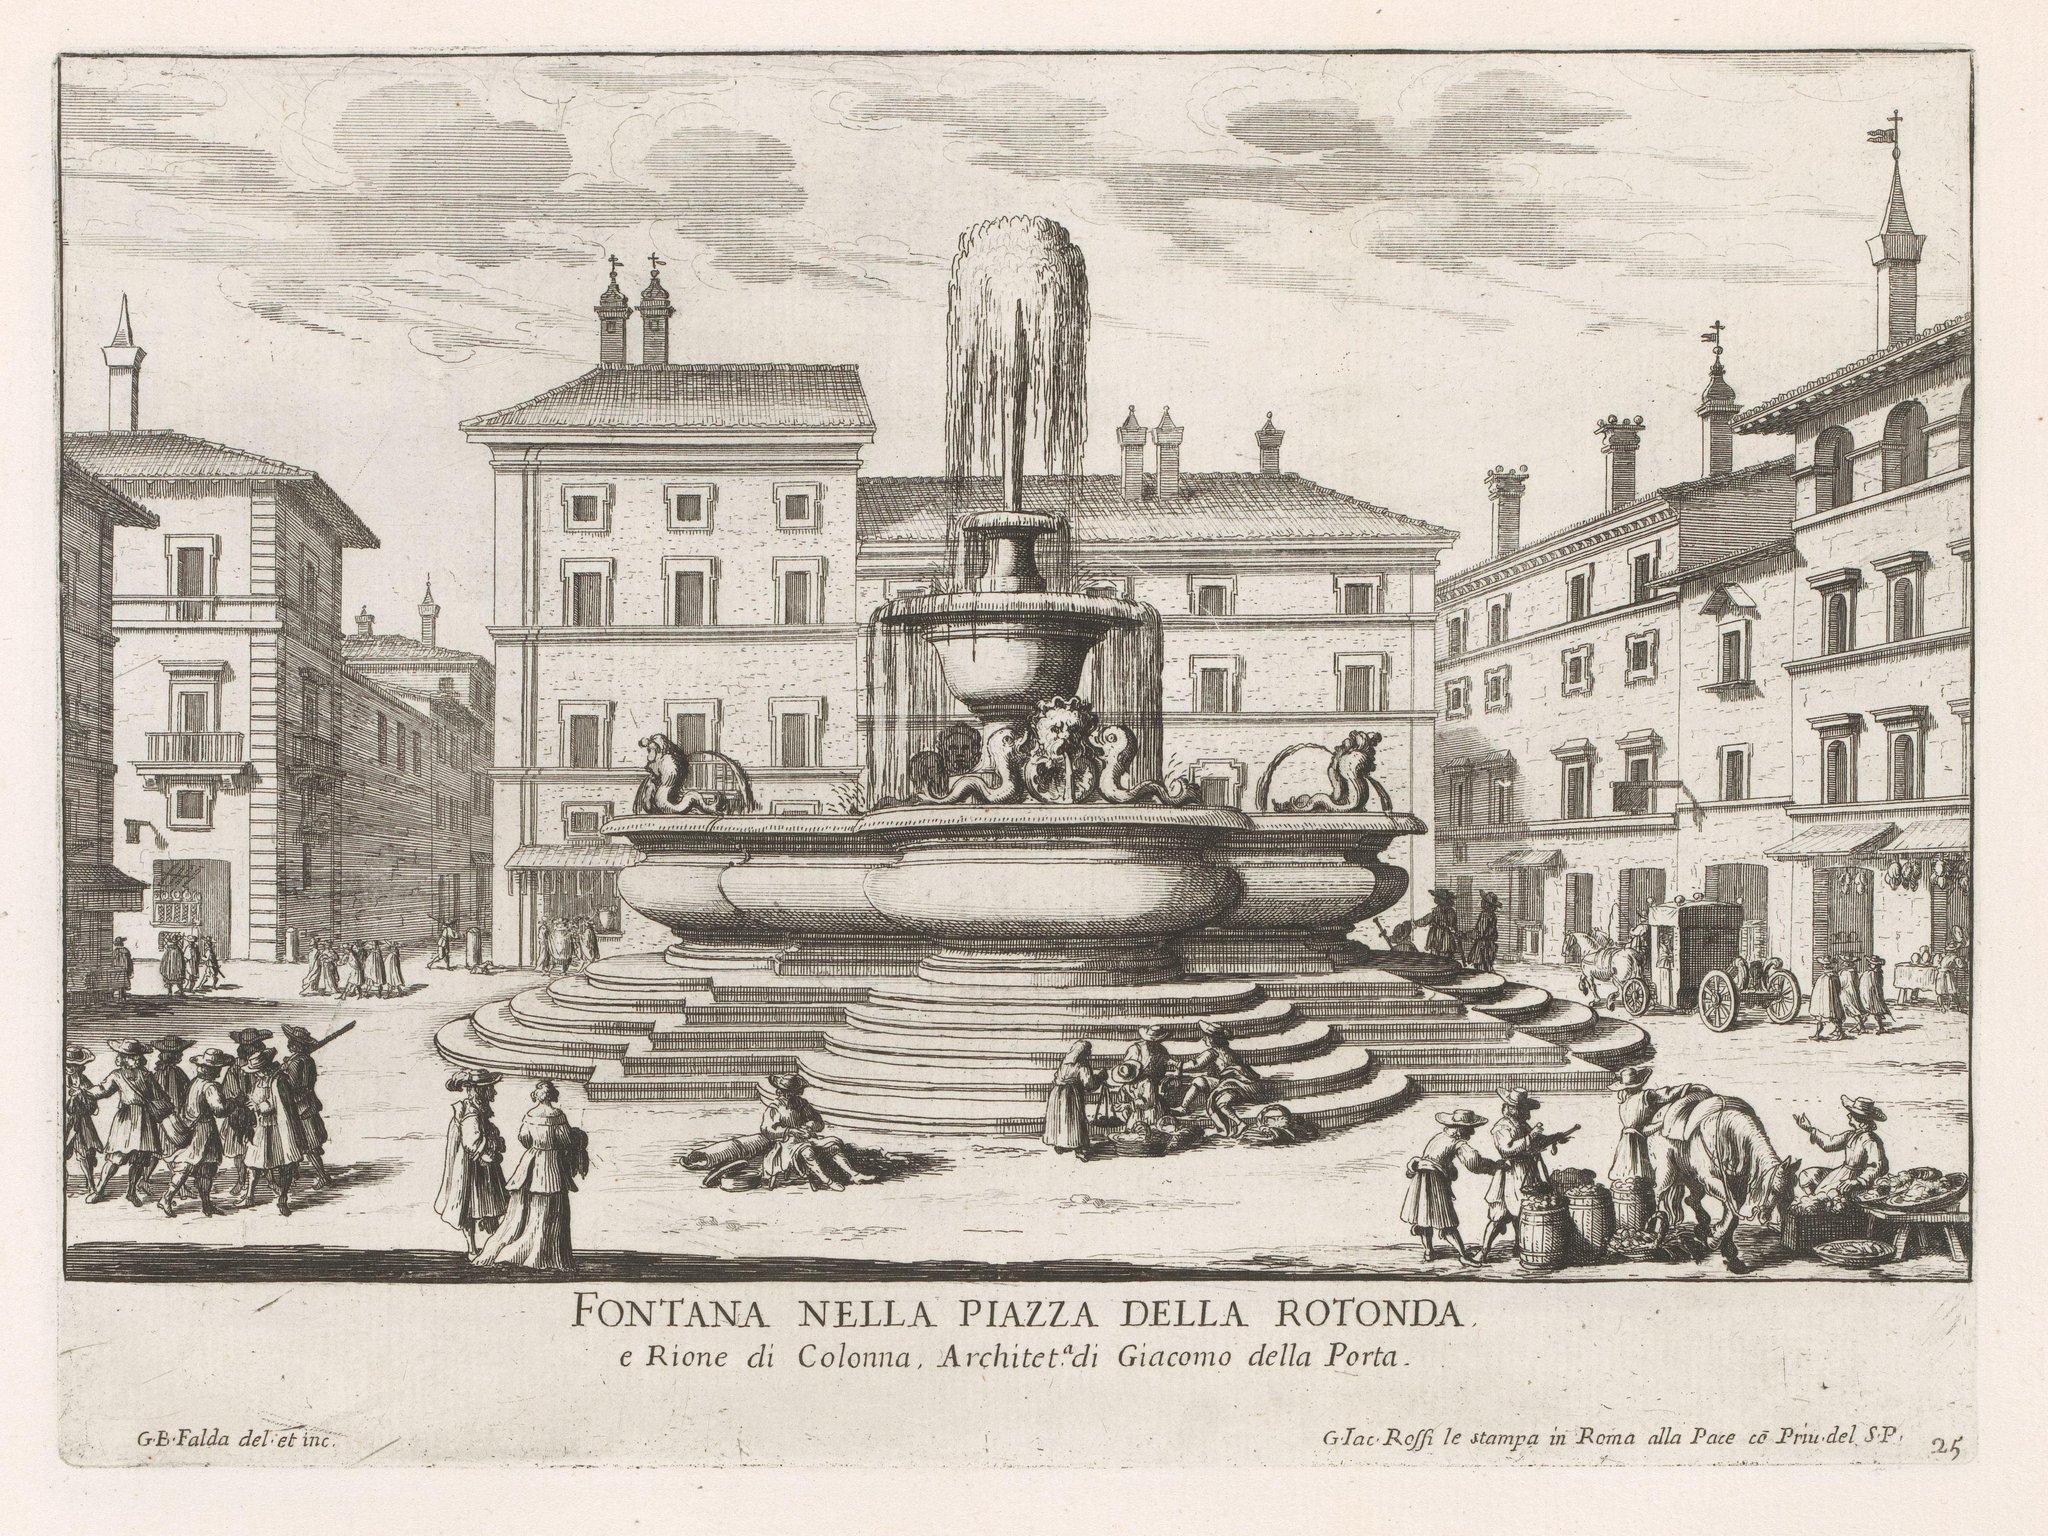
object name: album leaf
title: Fontane di Roma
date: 1653-1691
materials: paper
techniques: etching, intaglio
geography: italy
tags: ornamental fountain, rome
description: Genummerd rechtsonder: 25. De prent maakt deel uit van een album.